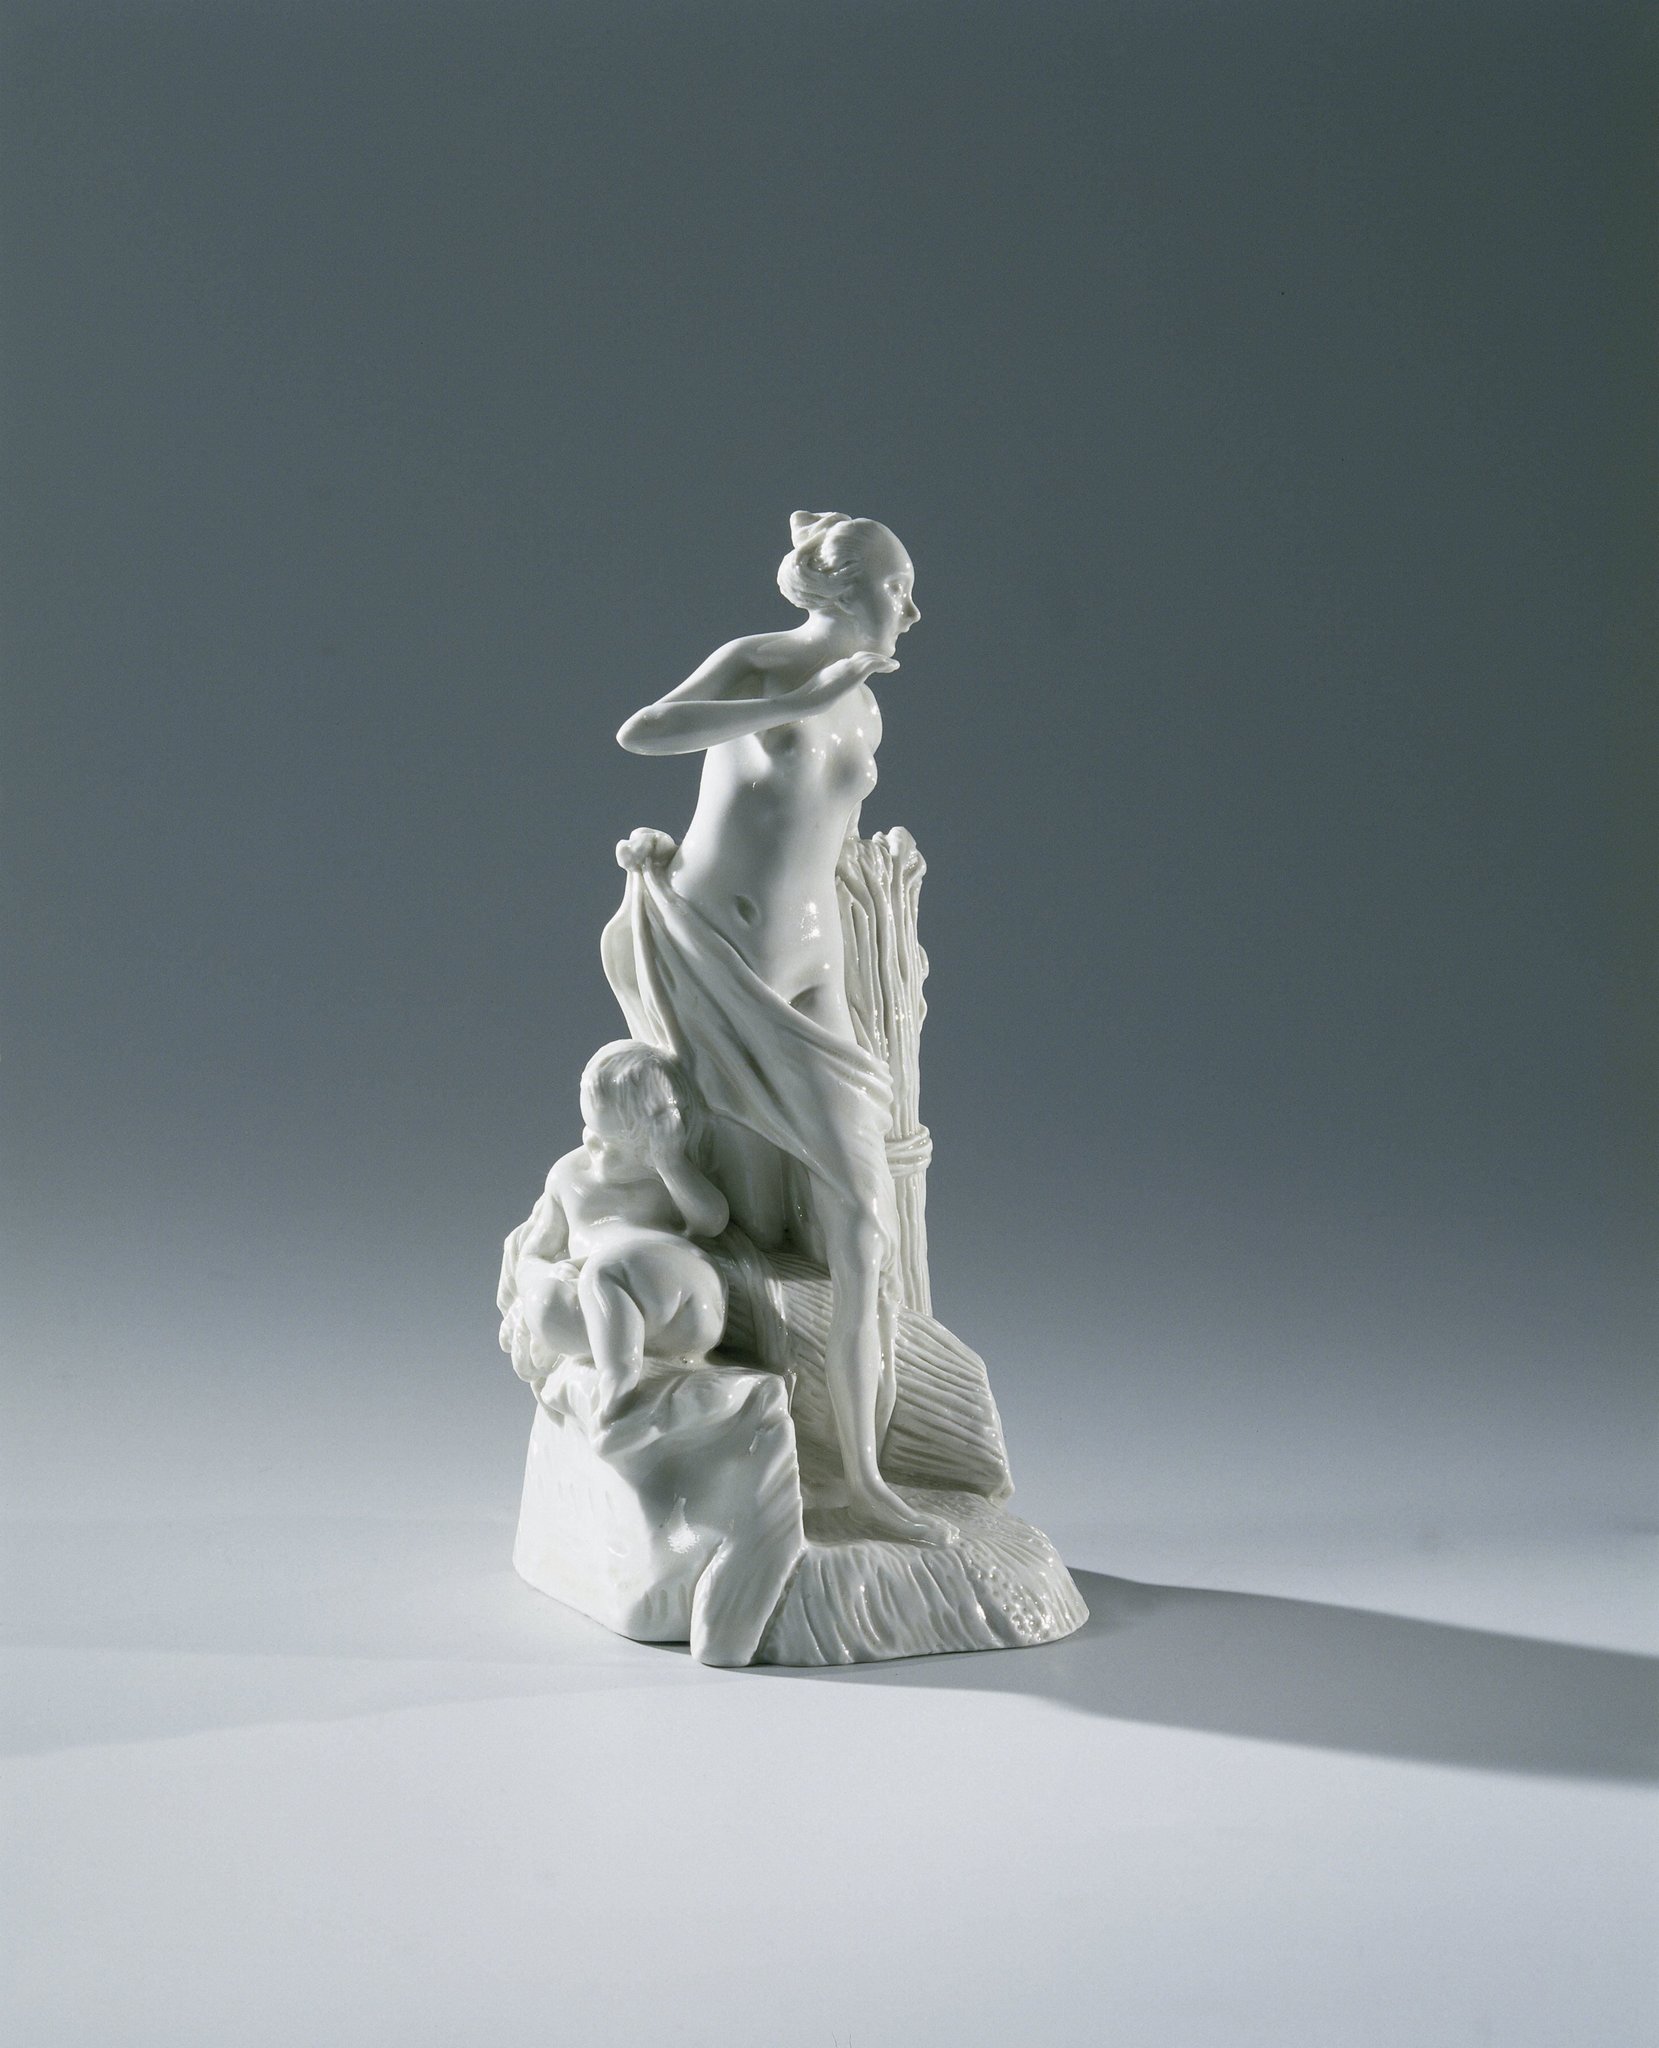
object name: figure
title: De Zomer, uit een serie van de Vier Jaargetijden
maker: christian gottlob berger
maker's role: garneerder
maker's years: 1730-1776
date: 1760-1761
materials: porcelain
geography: weesp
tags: summer, 'aestas'; 'estate' (ripa)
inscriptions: factory mark: ‘Gekruiste zwaarden en drie bollen in blauw onder de glazuur.’, check stamp: ‘I’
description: Group of Summer. Porcelain, c. 1760 - 1770. Weesp, c. 1760 - 1770. Factory of Betram, Count Gronsveld-Diepenbroick.